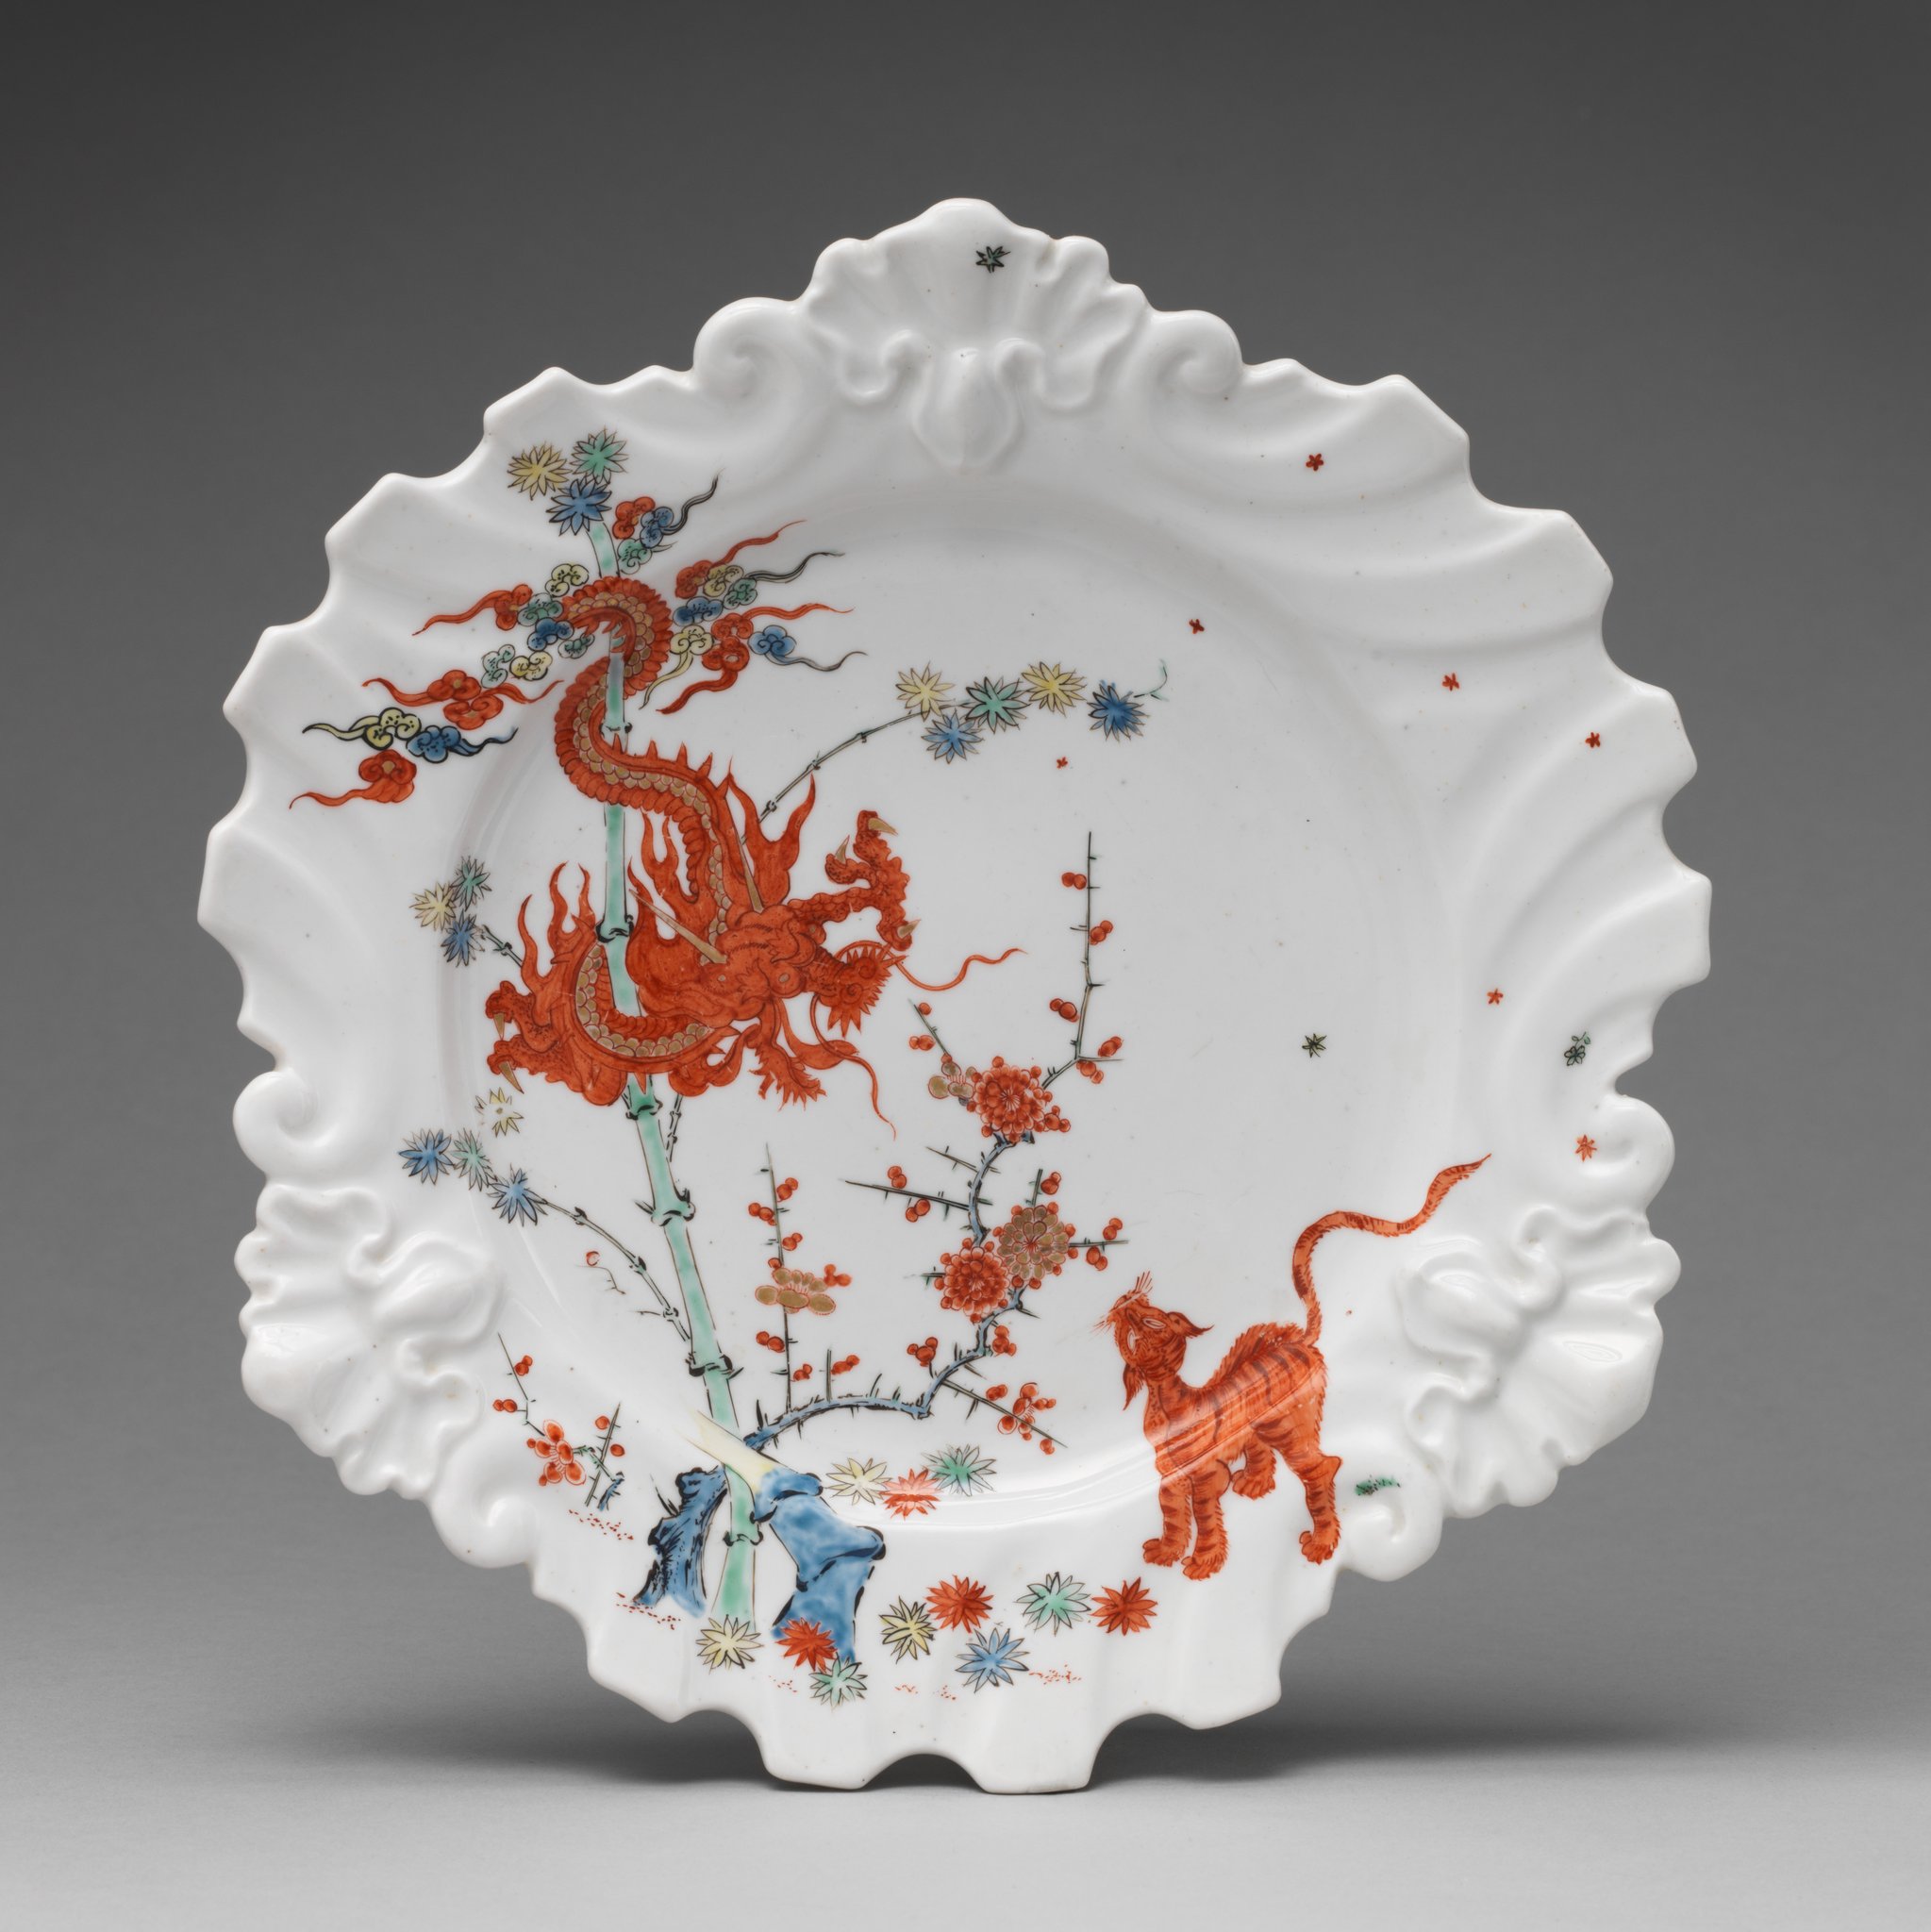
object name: plate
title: Plate decorated with Japanese Kakiemon-inspired scene with twisted dragon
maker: chelsea porcelain manufactory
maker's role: factory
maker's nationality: british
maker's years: 1744-1784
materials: soft paste porcelain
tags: dragons,tigers